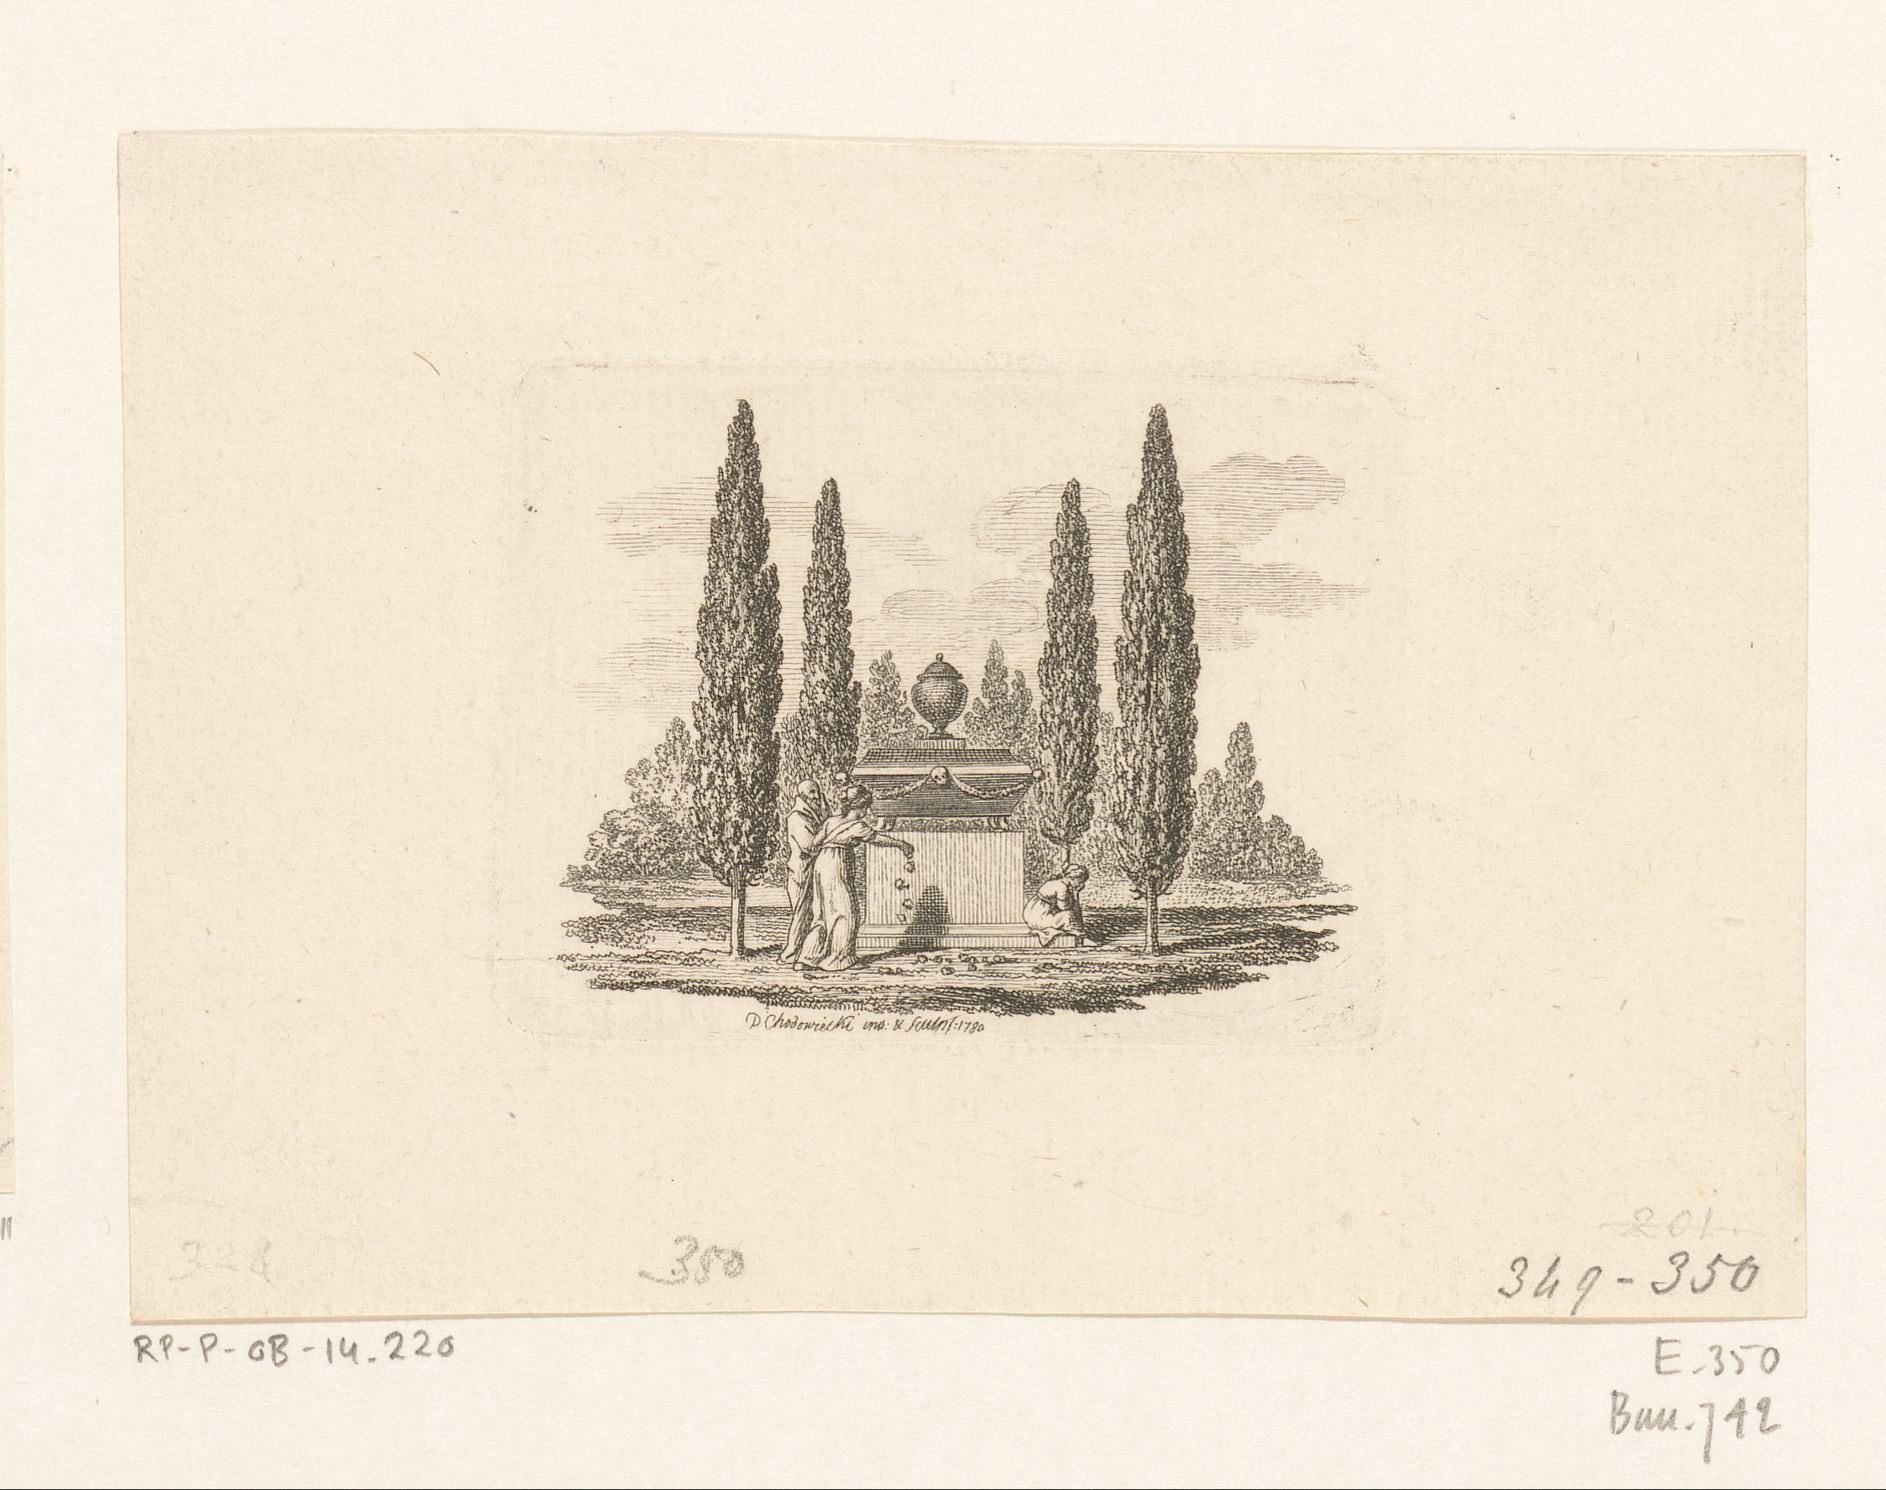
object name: print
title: Treurende figuren en een bloemen strooiende vrouw voor een grafmonument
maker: daniel nikolaus chodowiecki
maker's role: draughtsman, print maker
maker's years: 1726-1801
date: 1780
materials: paper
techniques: etching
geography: berlin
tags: trees: cypress, landscapes, mourning customs, sarcophagus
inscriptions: collector's mark: Lugt 2228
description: Prent gebruikt voor: Chapon, Gottlob Friedrich Wilhelm. Leben und letzte Stunden der weiland Durchlauchtigsten Fürstinn Casimire (...). Lemgo: Meyersche Hofbuchhandlung, 1780.